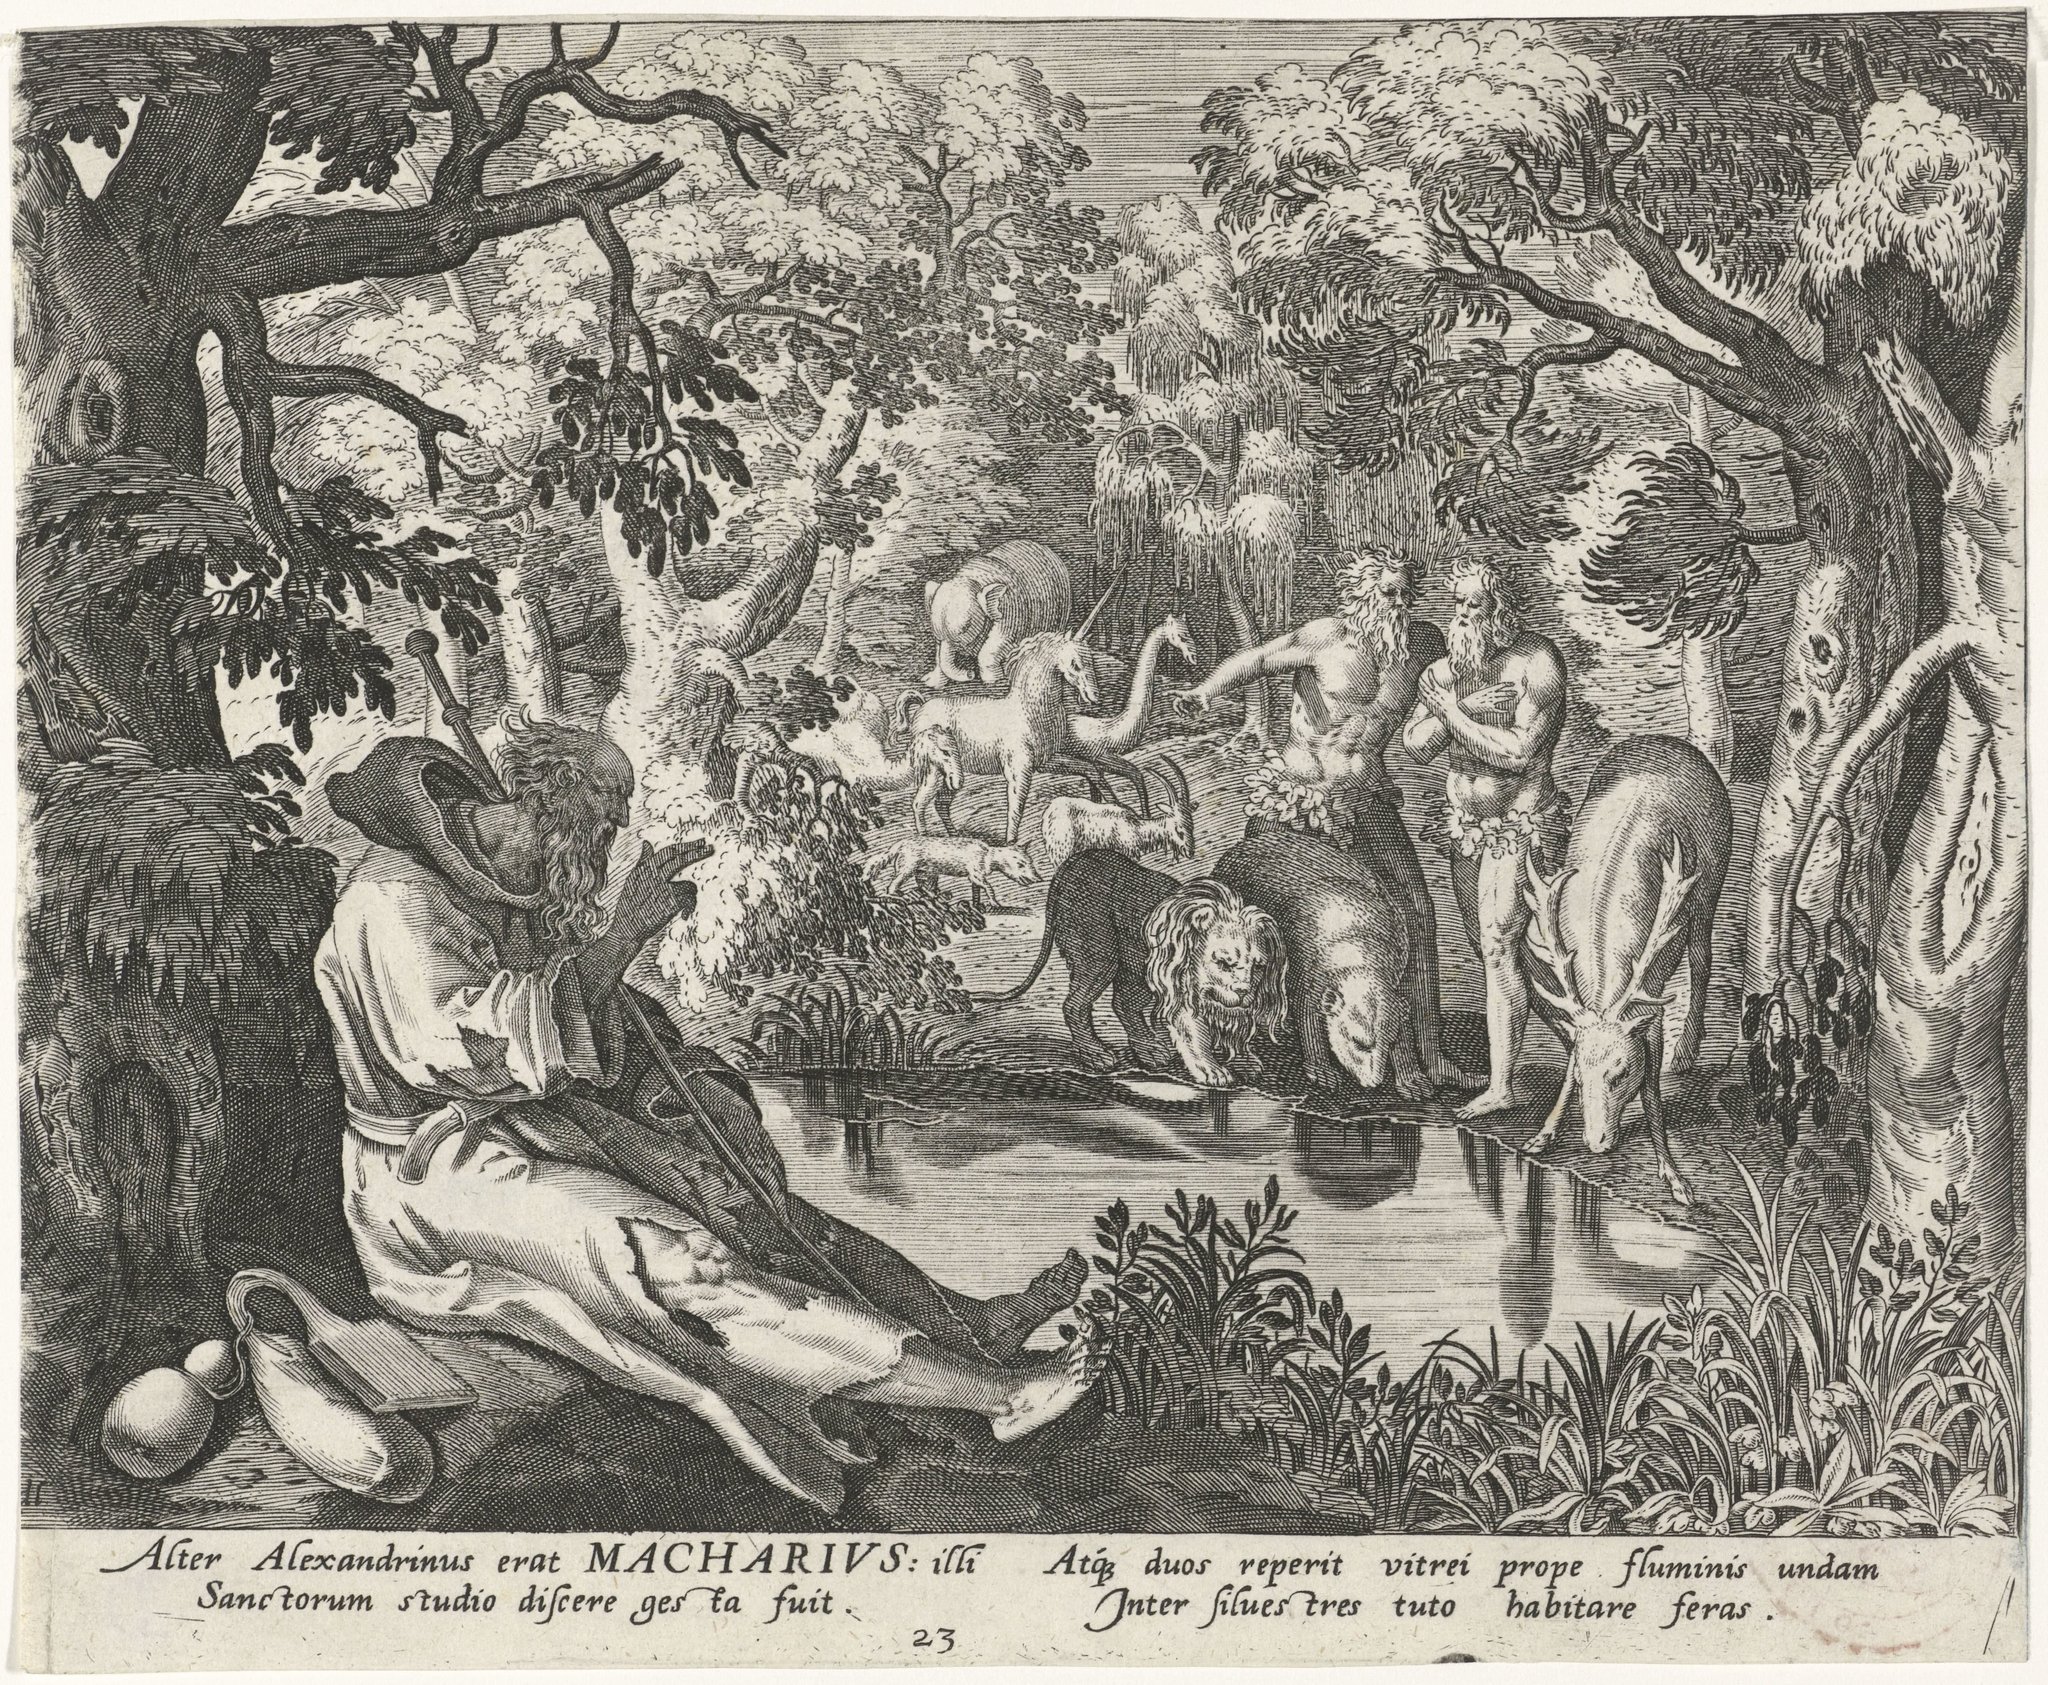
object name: print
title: Solitudo Sive Vitae Patrum Eremicolarum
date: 1583-1588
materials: paper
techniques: engraving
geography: antwerp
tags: male saints (with name), unicorn, animals, wild man, wodewose, woodehouse, anchorite, hermit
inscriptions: collector's mark: Lugt 240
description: De H. Macarius van Alexandrië als kluizenaar in de wildernis. Hij zit tegen een boom en maakt een zegenend gebaar. Op de achtergrond wilde dieren en twee wildemannen.